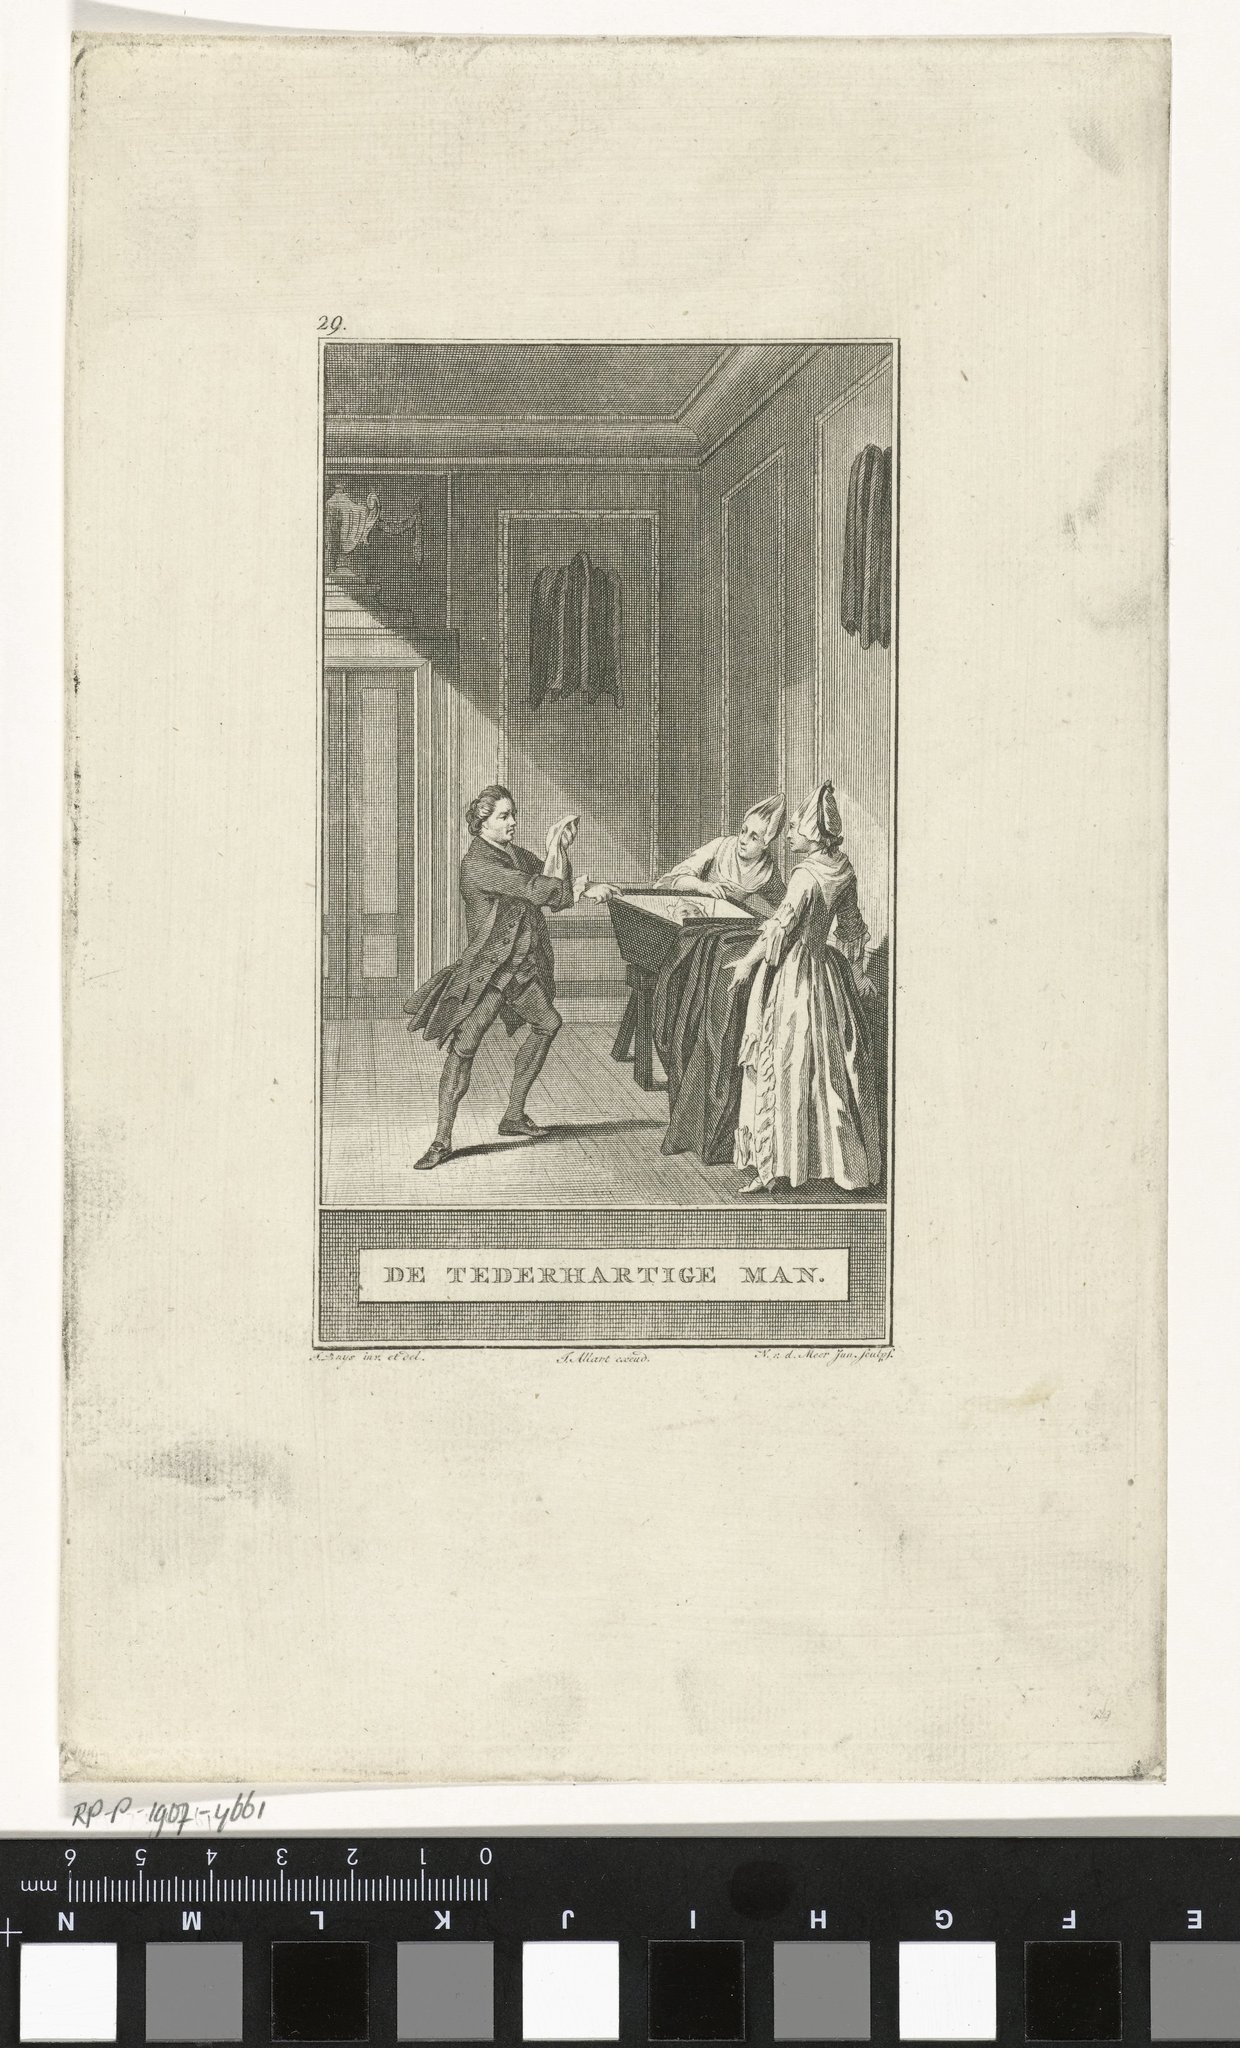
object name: print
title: Echtgenoot bij zijn opgebaarde vrouw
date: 1778-1785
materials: paper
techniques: etching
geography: amsterdam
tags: coffin, maid ~ house personnel, index finger forwards, pointing, indicating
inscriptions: collector's mark: Lugt 2228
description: Prent bij: Gellert, Christian Fürchtegott. Fabelen en vertelsels. 3 dln. Amsterdam: Pieter Meyer, 1772-1774. De prenten bij deze publicatie werden later uitgegeven. De exemplaren uitgegeven door de weduwe Jacobus Loveringh & Johannes Allart tussen 1777 en 1778, de exemplaren uitgegeven door alleen Johannes Allart tussen 1778 en 1785.